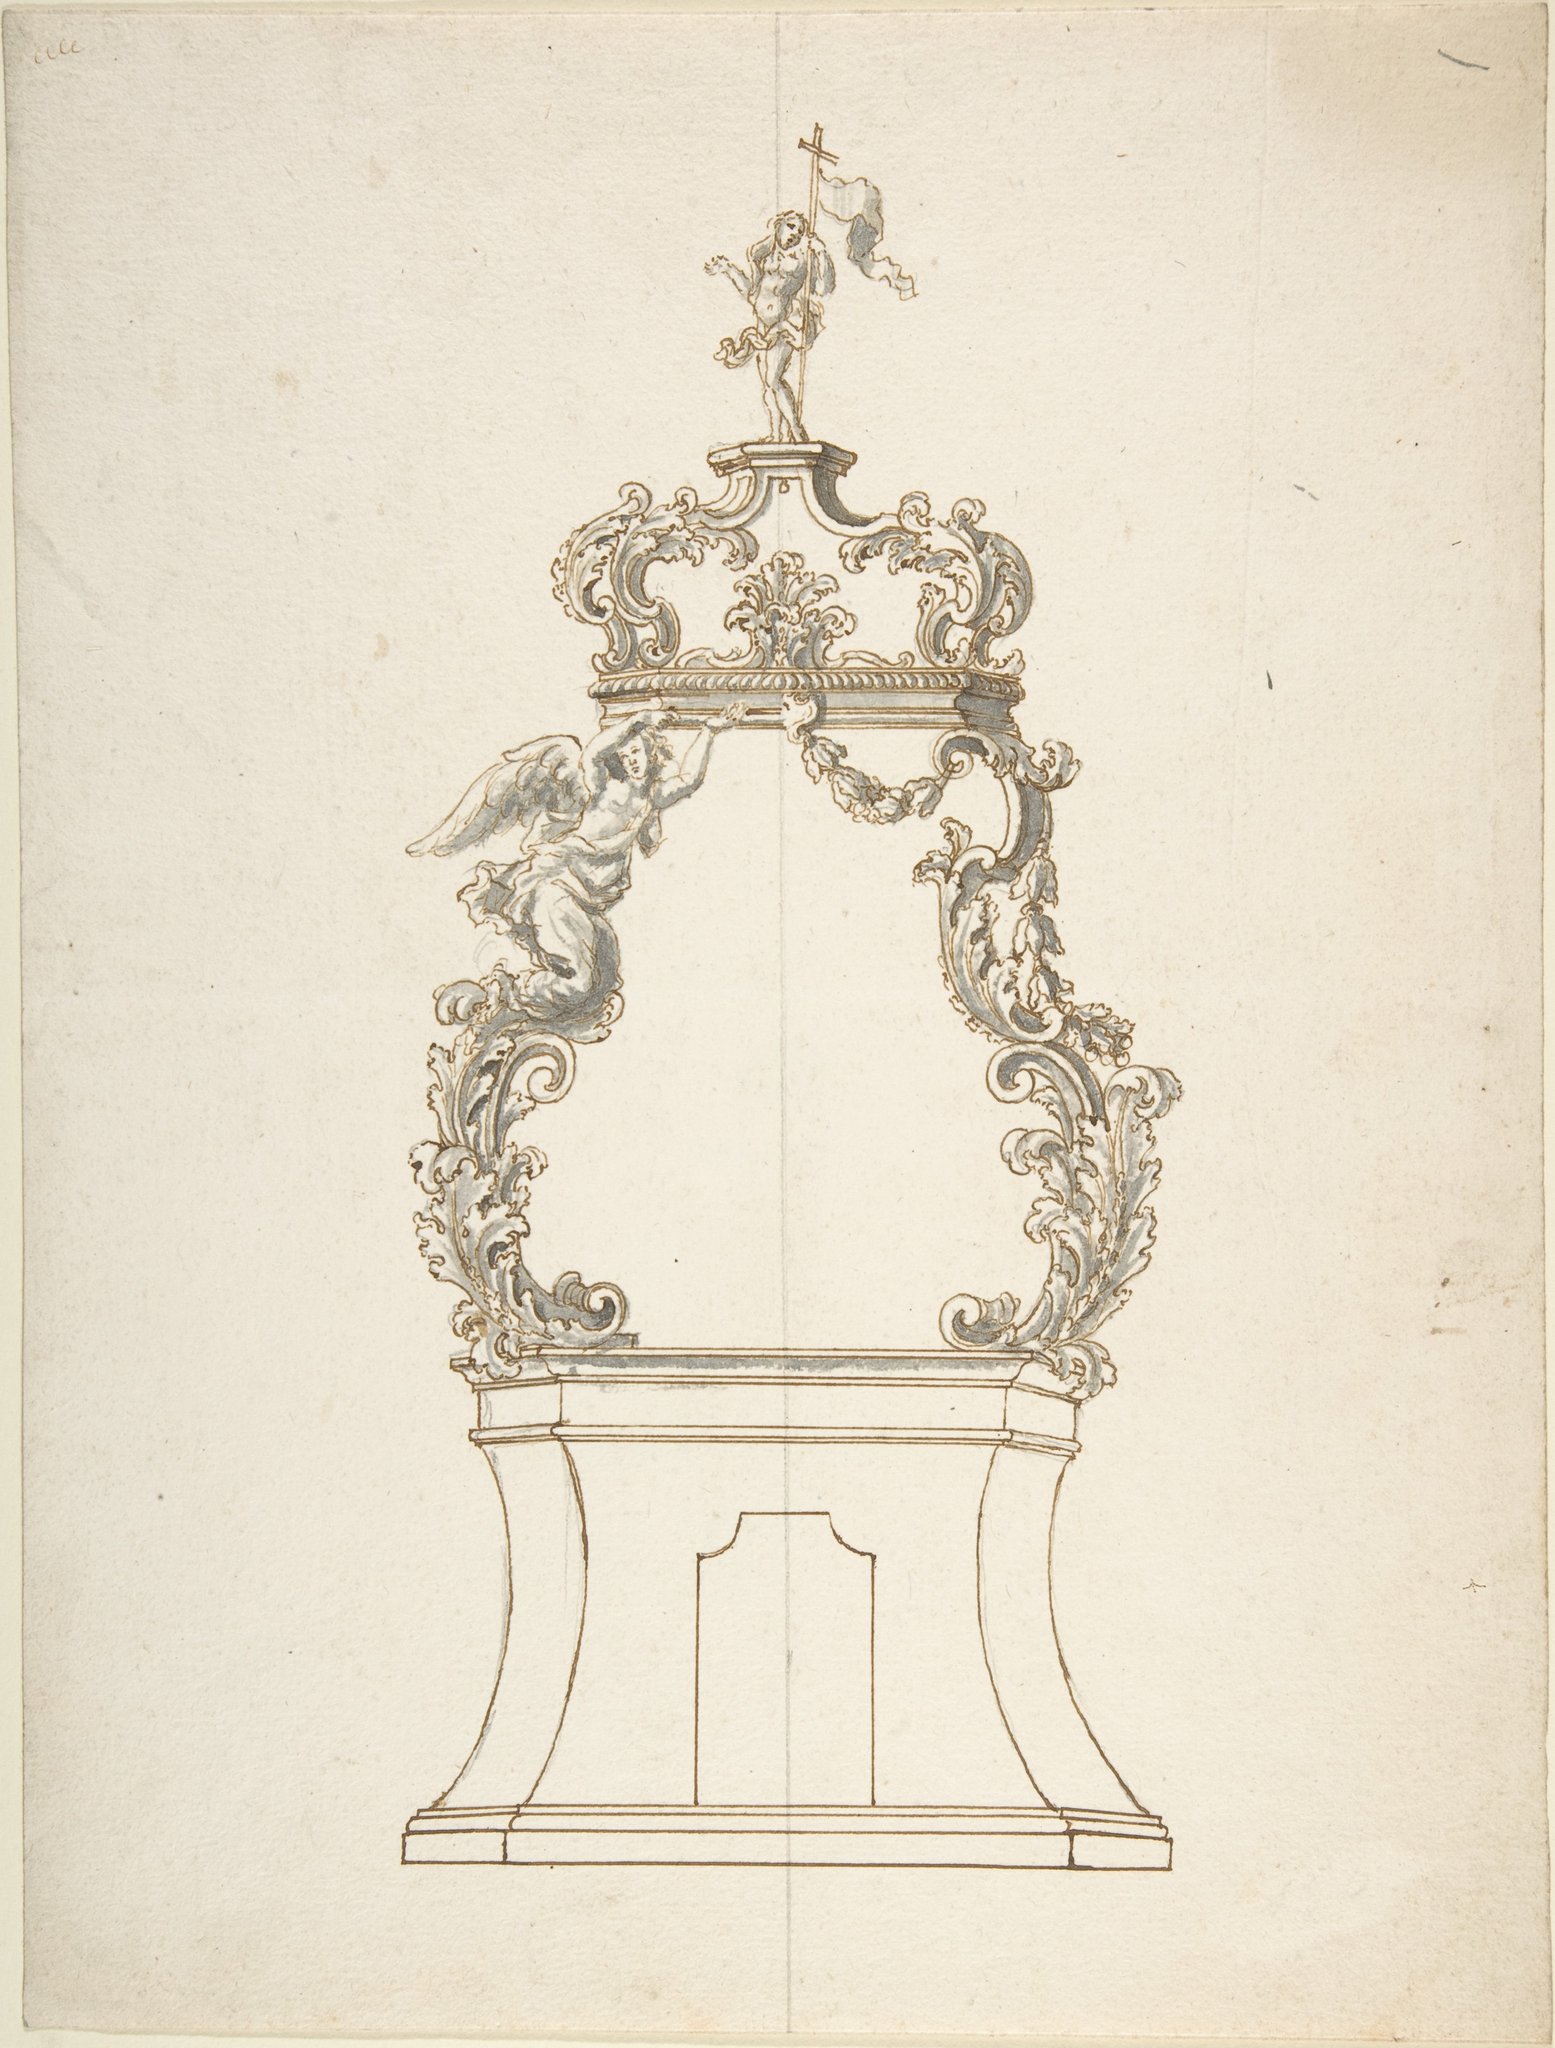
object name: drawing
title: Design for a Monstrance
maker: anonymous, italian, 18th century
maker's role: artist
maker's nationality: italian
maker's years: 1700-1800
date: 1701-1800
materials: ink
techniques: pen, wash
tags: angels,cross